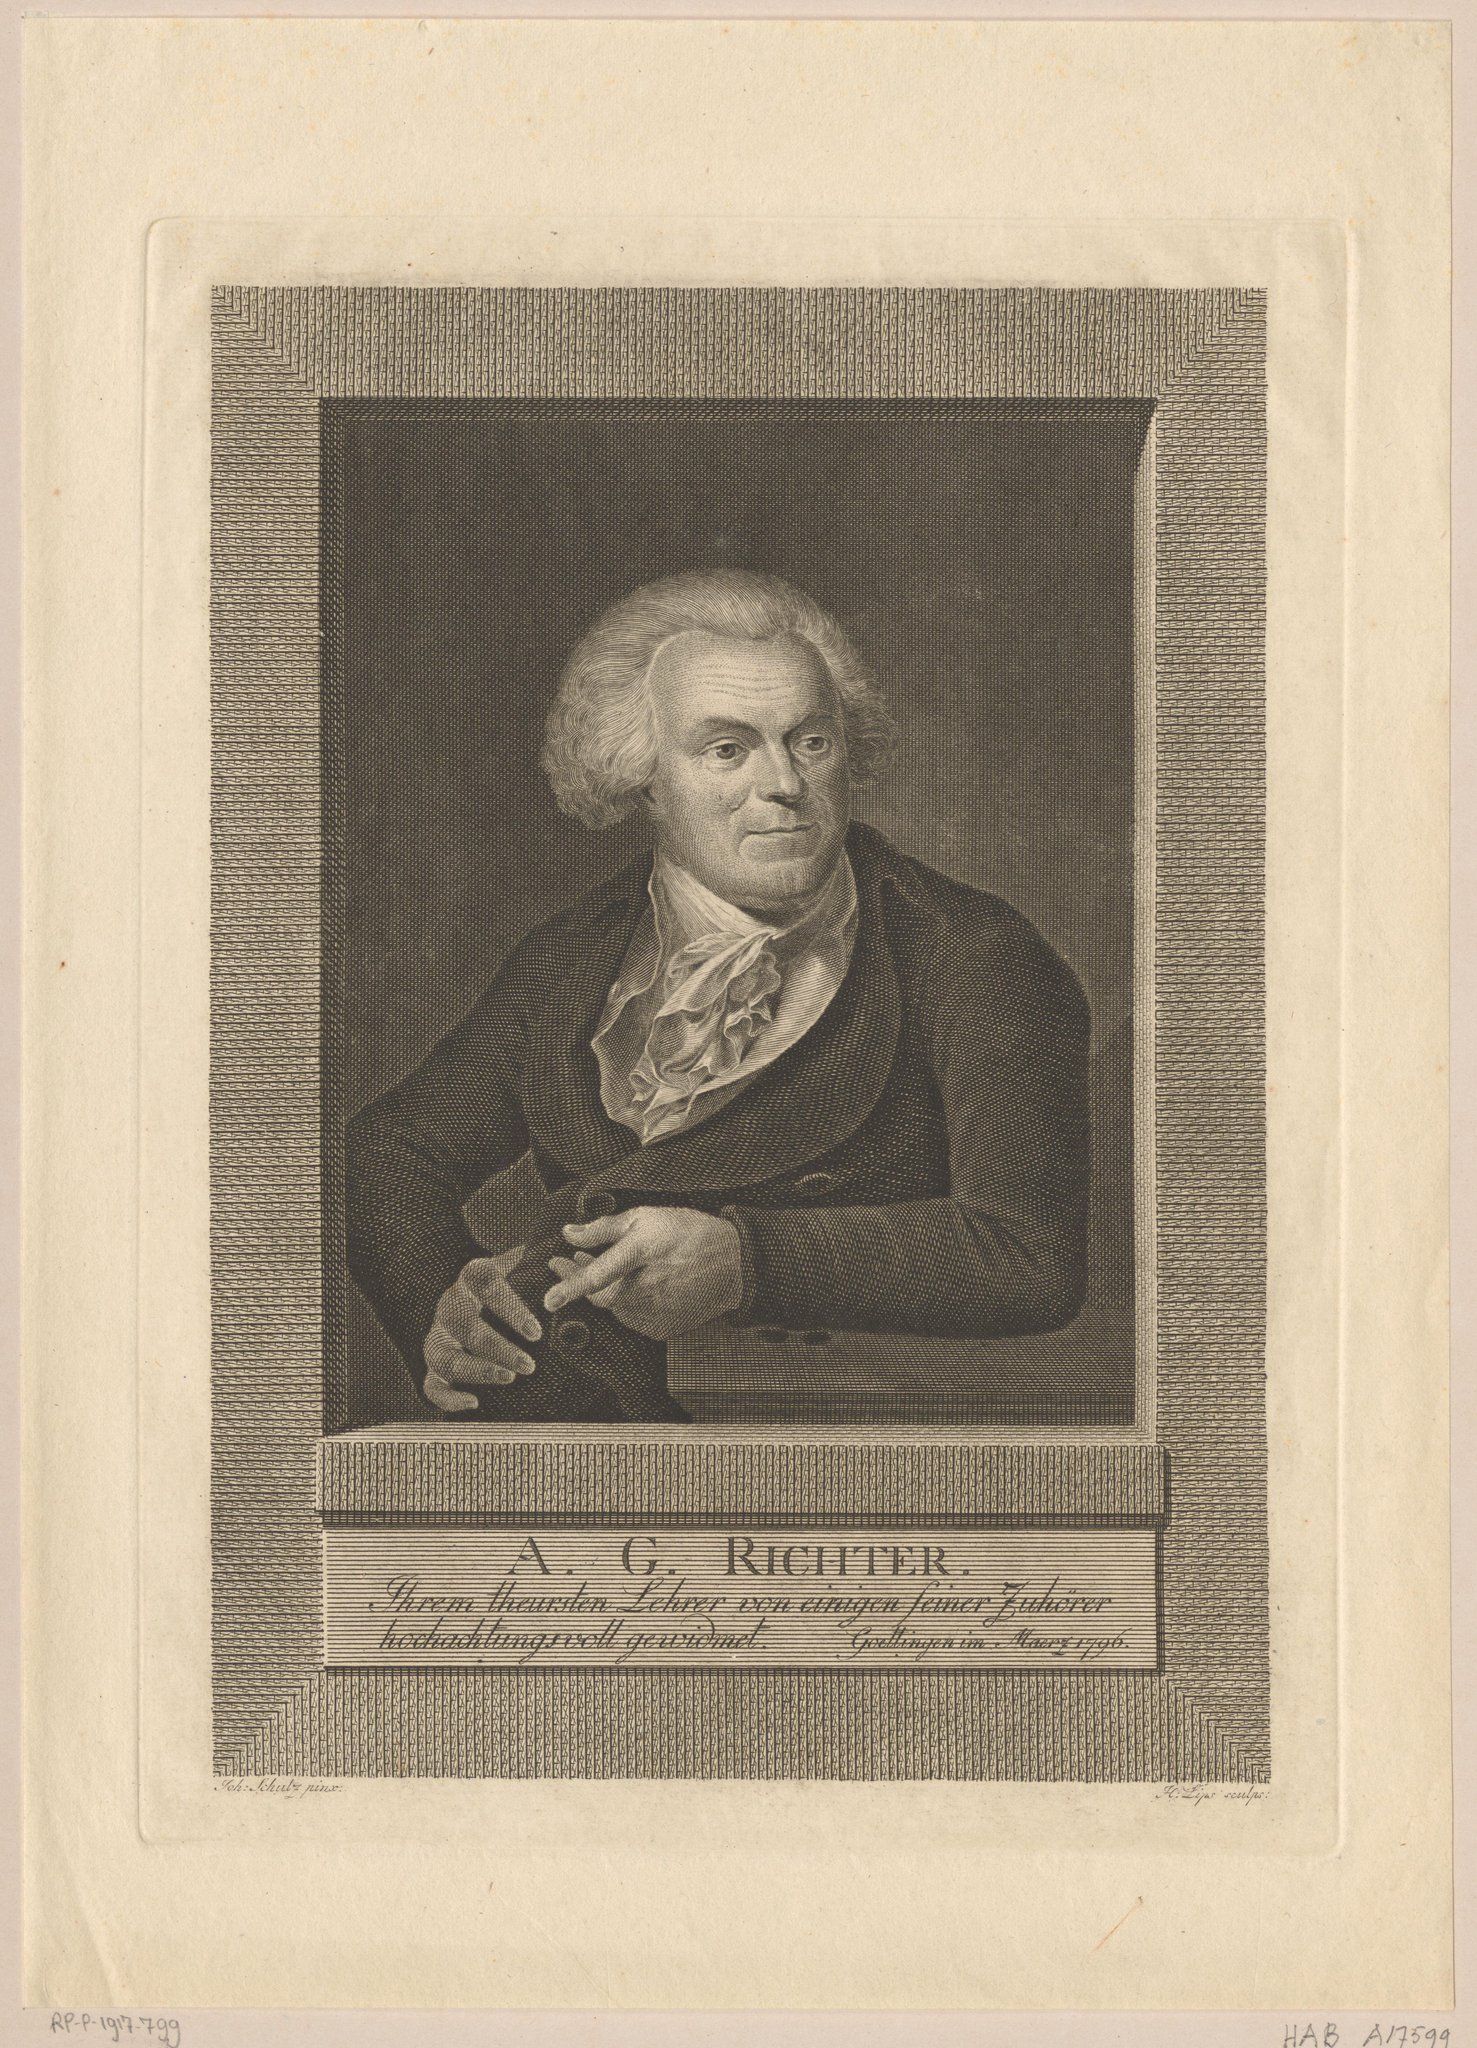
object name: print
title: Portret van August Gottlieb Richter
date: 1796-1817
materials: paper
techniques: engraving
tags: historical persons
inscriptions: collector's mark: Lugt 2228